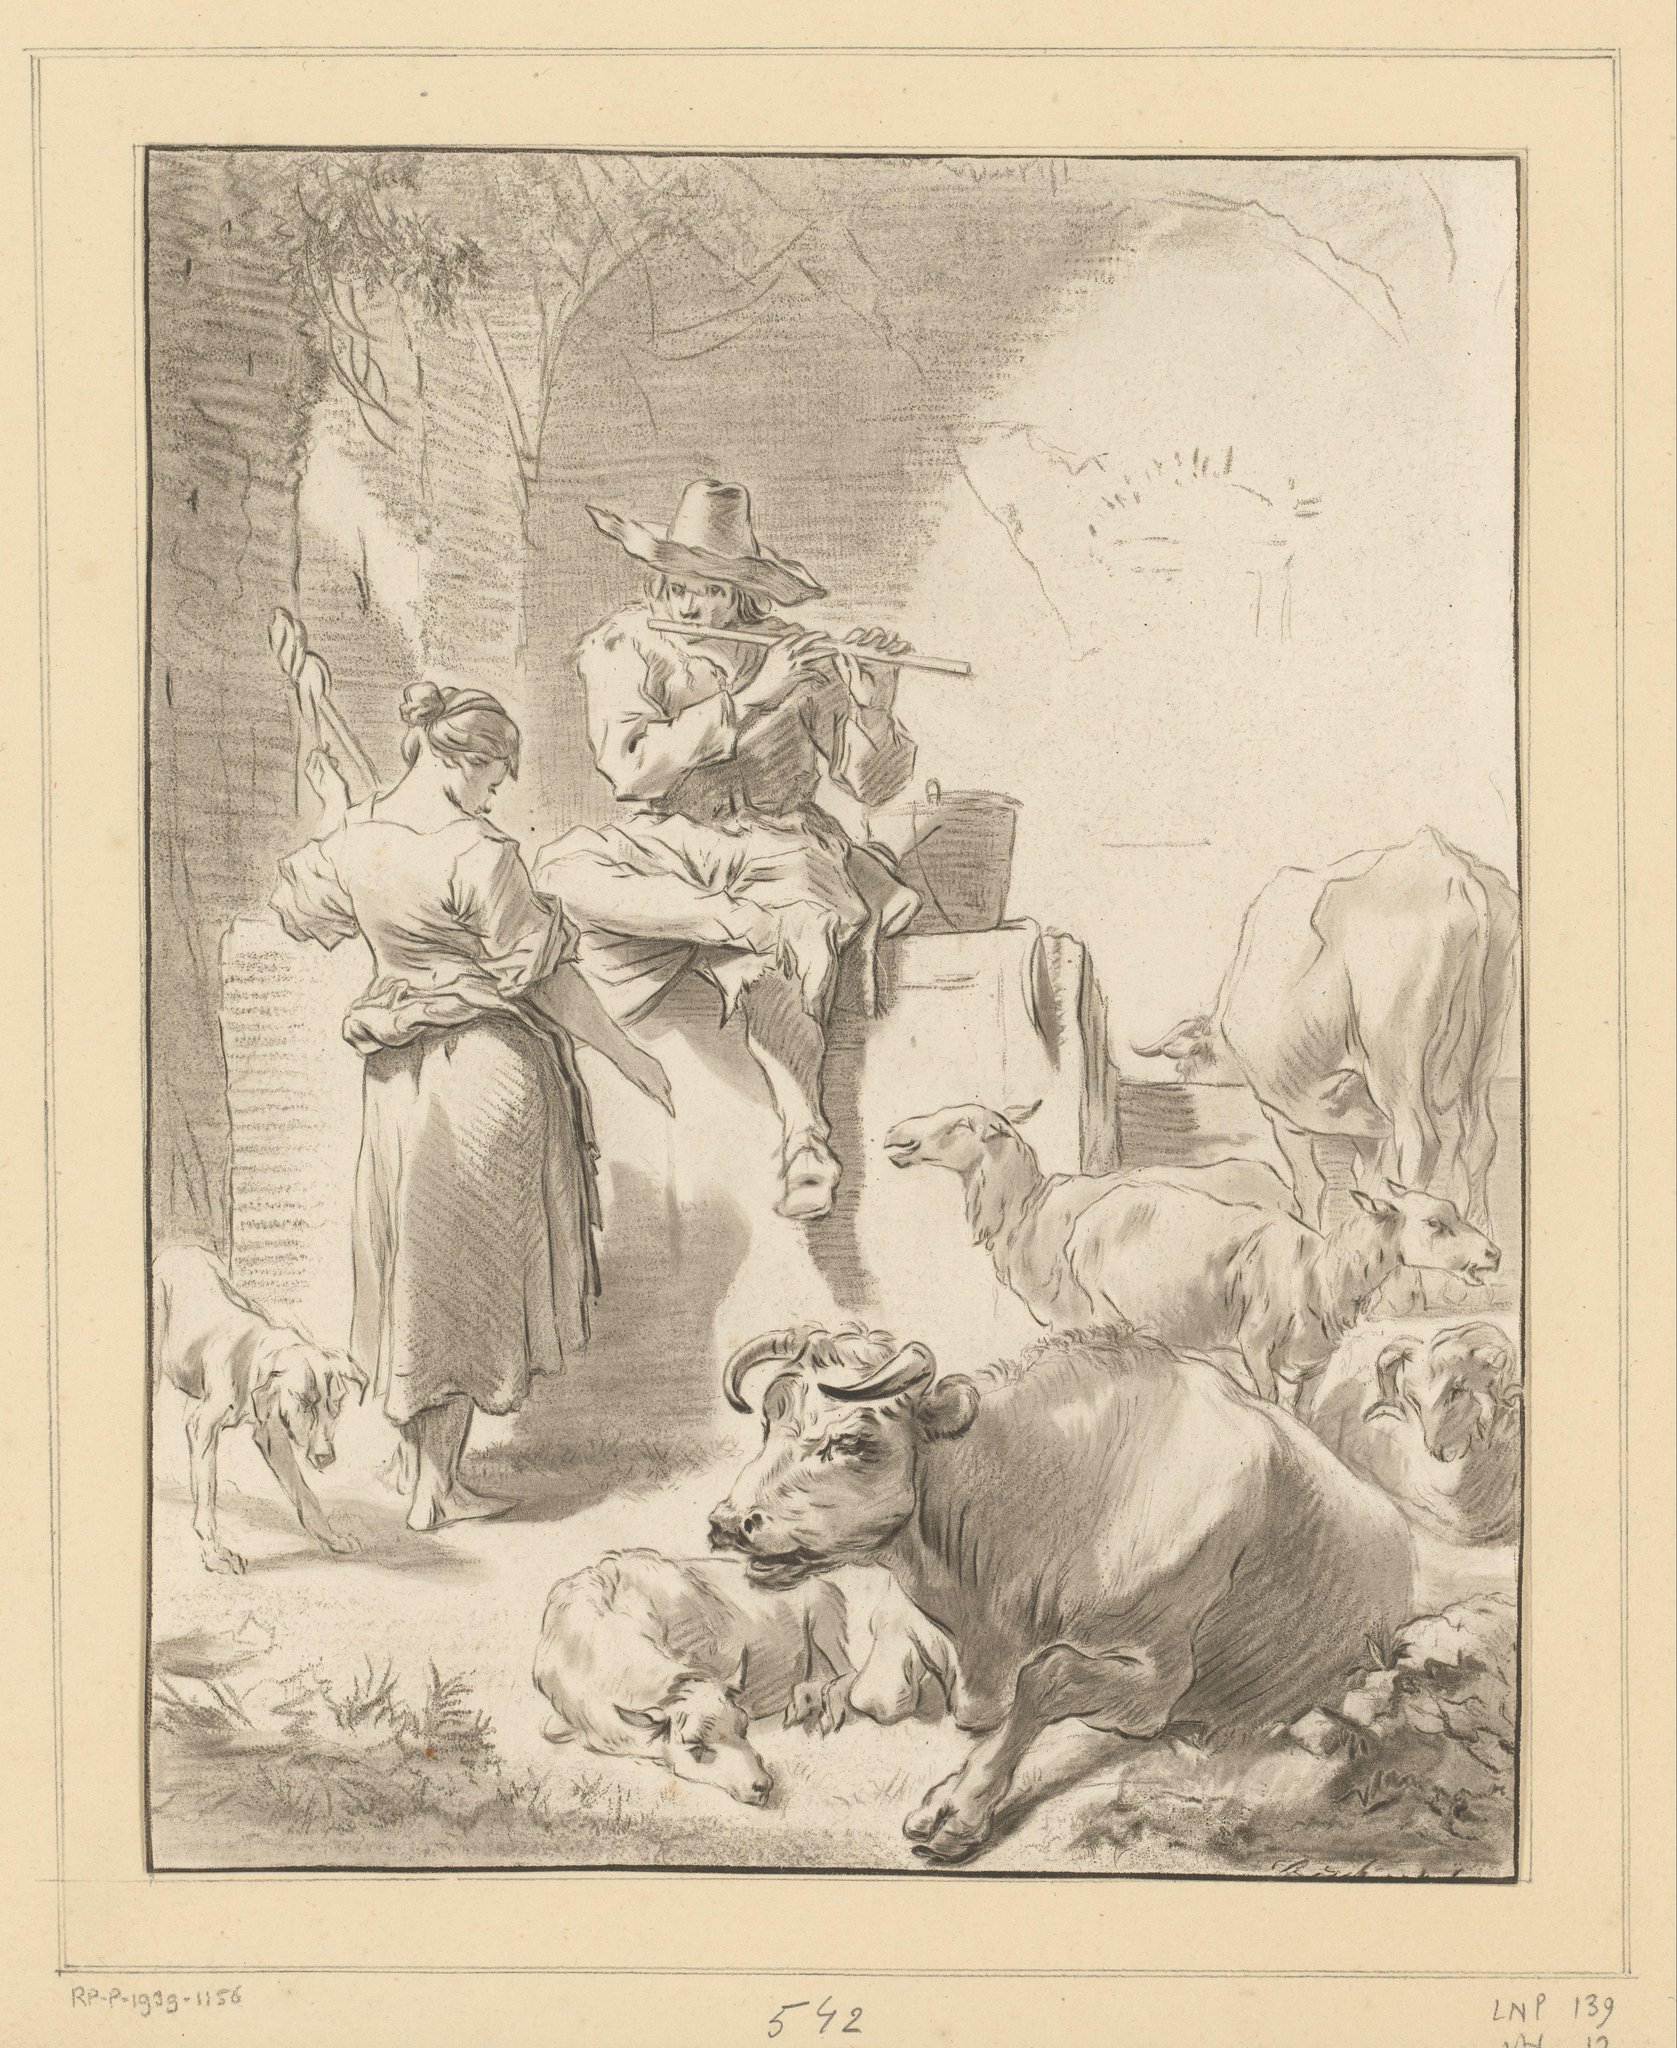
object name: print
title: Fluitspelende herder en spinnende herderin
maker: jurriaan cootwijck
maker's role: print maker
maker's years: 1714-1798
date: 1724-1798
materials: paper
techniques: printmaking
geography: amsterdam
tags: one person playing wind instrument - cc - out of doors, herding, herdsman, herdswoman, shepherd, shepherdess, cowherd, etc., spinning (manufacture of yarn), herd, flock, flute, aulos, tibia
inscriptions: collector's mark: ‘RIJKS / MUSM’, inscription: ‘J Cootwijk/ Fecit’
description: Een herder zit op een rots en speelt fluit. Naast hem staat een herderin die spint. Geiten en koeien liggen rondom het paar. Onder de prent een potloodtekening van een man met een hoed. De prent ligt los in een album, zie blad 139.